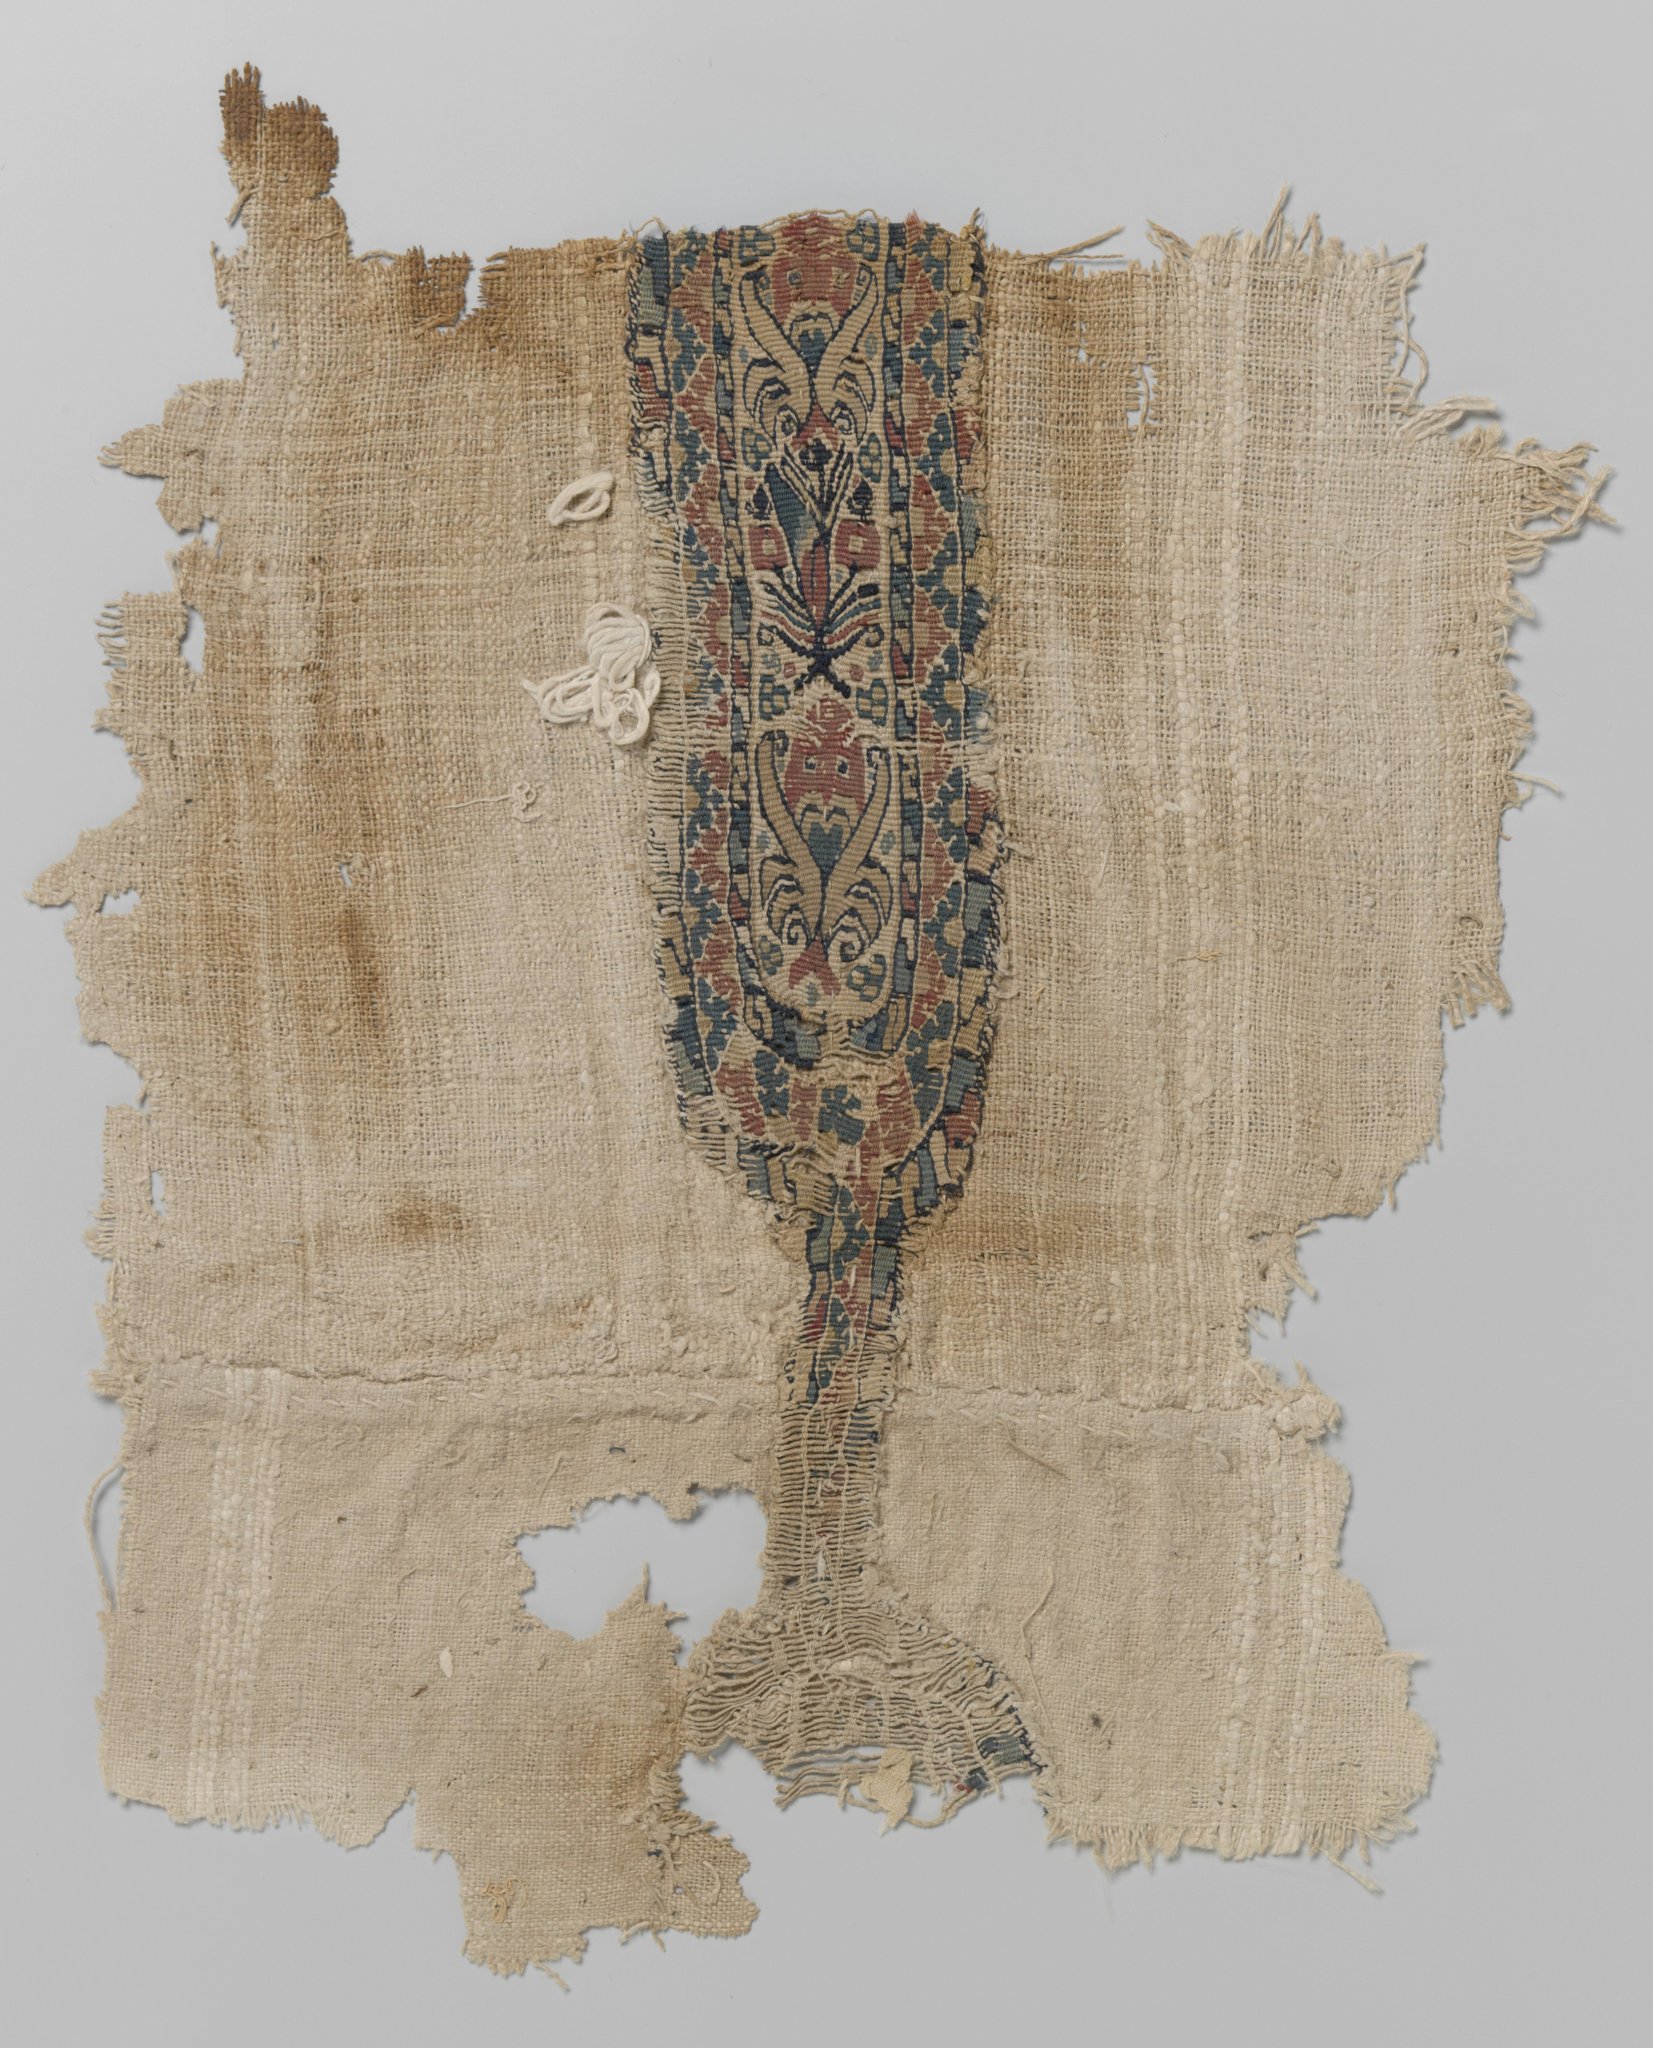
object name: clavus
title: Weefselfragment met clavus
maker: Anonymous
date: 600-799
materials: linen, wool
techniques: weave, tapestry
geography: egypt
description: Grof naturelkleurig linnen weefselfragment bestaande uit twee aan elkaar genaaide stukken, waarop een veelkleurig (geel, rood, donkerblauw, lichtblauw, zwart) clavus genaaid is. In het midden van de clavus bevindt zich een gestileerde bloementuil en uitwaaierende blakranken. Hier omheen drie randen met geometrische motieven. In het ondergrondweefsel op drie plaatsen strepen door verdikte inslagdraden en links naast de clavus twee toefjes lussen en een paar opstaande draden.